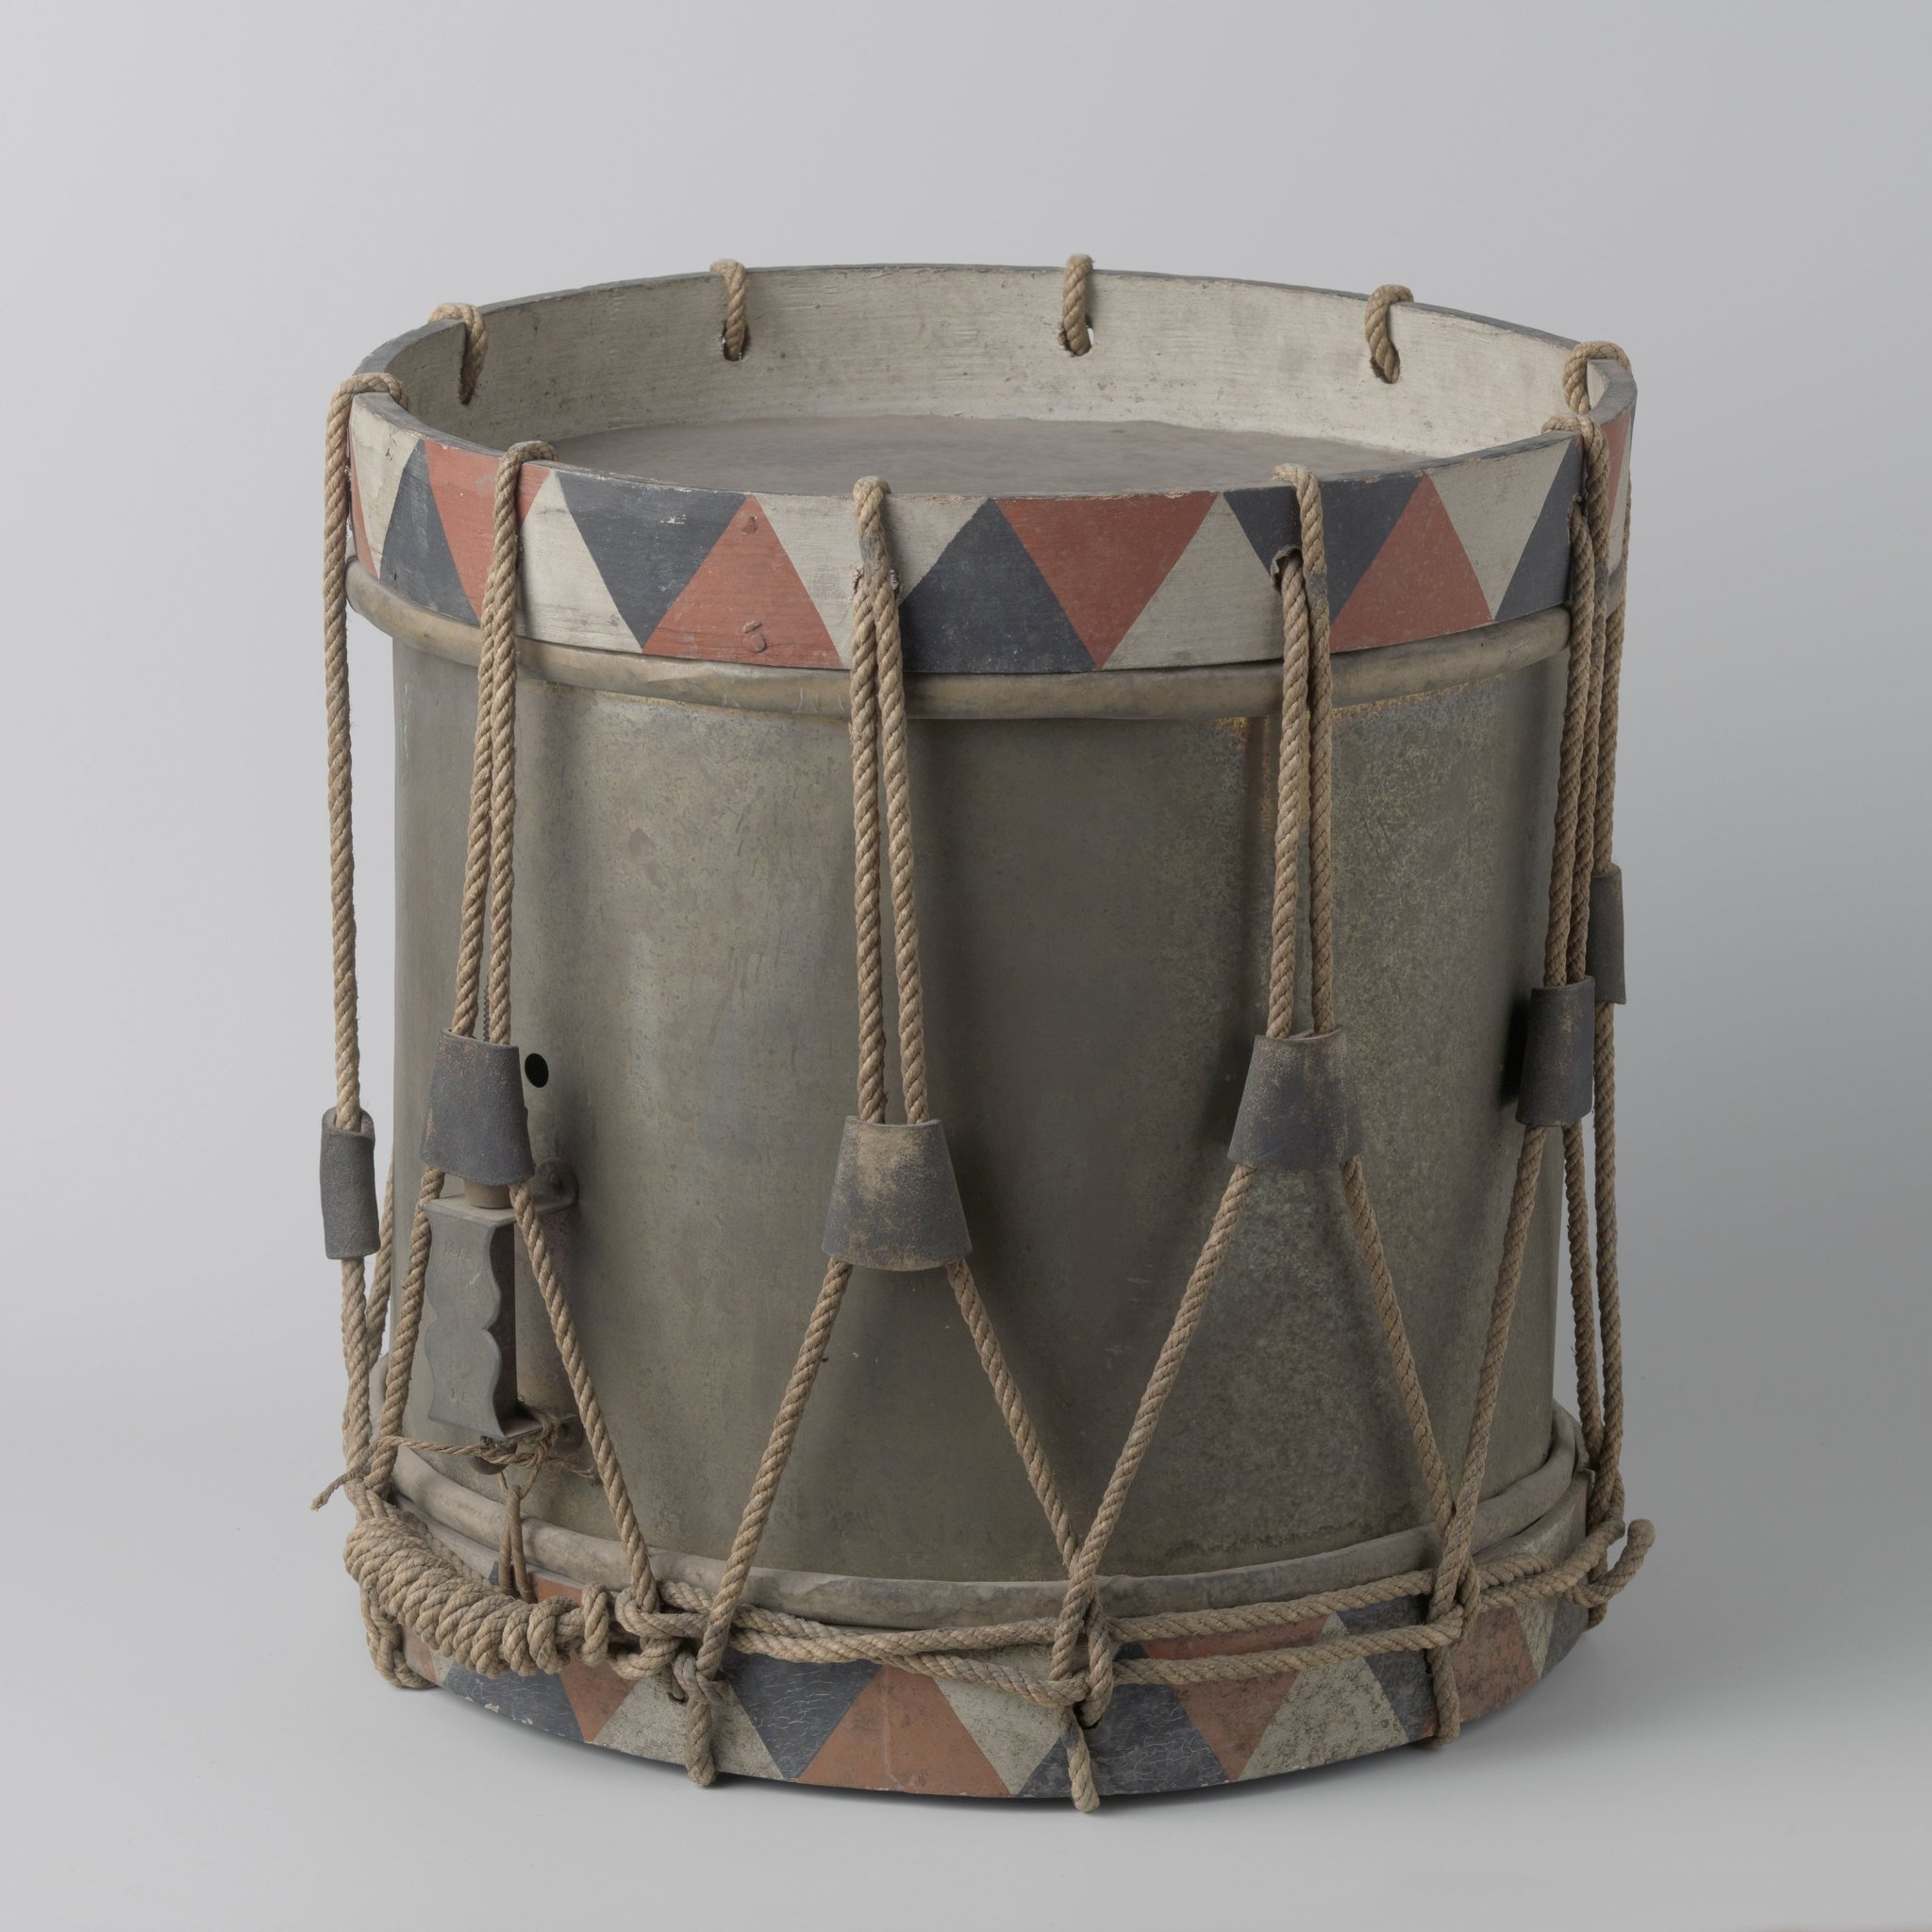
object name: musical instrument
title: Drum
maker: Anonymous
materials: brass, leather, fiber, wood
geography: netherlands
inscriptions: inscription: ‘1855-16’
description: Music has always been a crucial element of public celebrations, such as military parades, coronations, royal weddings, and funerals, adding grandeur to the solemnity of the occasion. Musical ensembles entrusted with performing music at these events have existed in Europe since the Middle Ages. This display highlights various marching bands and their musical instruments dating from the 16th to the 19th century.